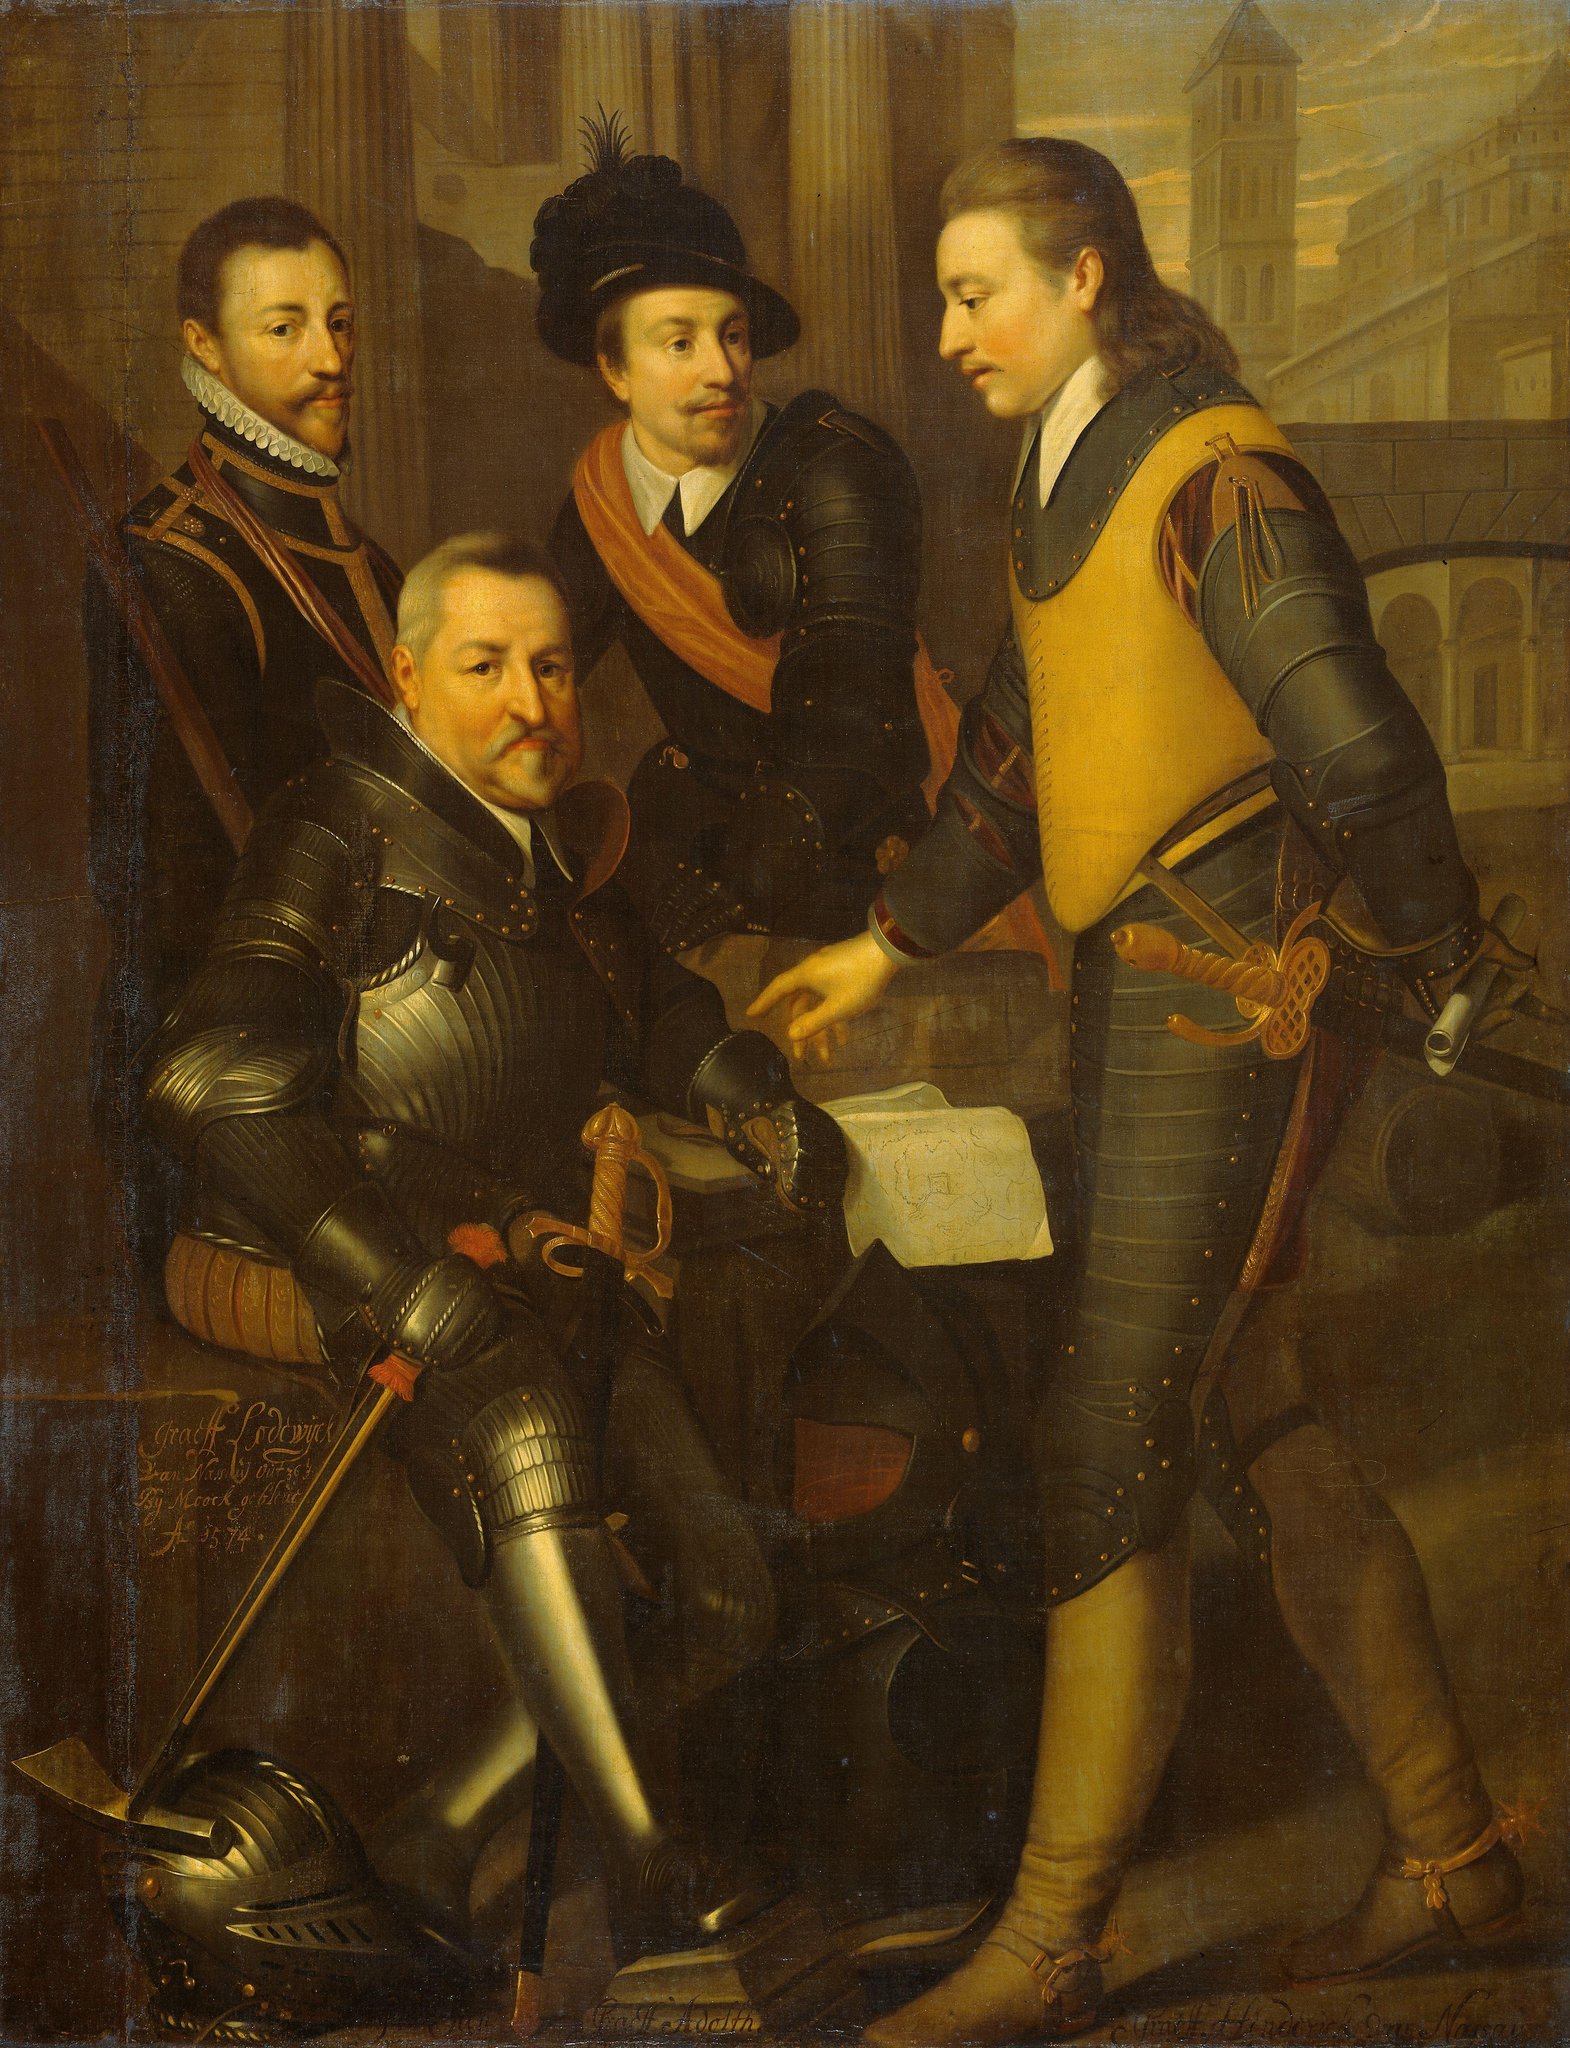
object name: painting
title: The Four Brothers of Willem I, Prince of Orange: Jan (1536-1606), sitting Hendrik (1550-74), Adolf (1540-68) and Lodewijk (1538-74)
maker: wybrand de geest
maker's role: draughtsman, painter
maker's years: 1592-1665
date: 1630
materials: canvas, oil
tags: delft, william i (prince of orange), historical persons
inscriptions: inscription, bottom left, in brown paint: ‘Gr Jan / van Nassa[.]’, inscription, left of Jan van Nassau, in beige paint: ‘Graeff Lodewijck / van Nassau out 36 J. / Bij Moock gebleve / Aº 1574’, inscription, bottom centre, in brown paint: ‘Graeff Adolfh Nassau / [..] heyliger[..] [...]’, inscription, bottom right, in brown paint: ‘Graeff. Henderick van Nassau / bij Moo[..] [...]’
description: De vier graven van Nassau-Dillenburg, de broeders van Willem I, prins van Oranje: Jan de Oude (zittend) Hendrik, Adolf en Lodewijk. Afgebeeld tegen een achtergrond van architectuur. Op de tafel tussen hen in ligt een landkaart, op de grond helmen en stukken van een harnas. Jan heeft een strijdhamer in de hand.